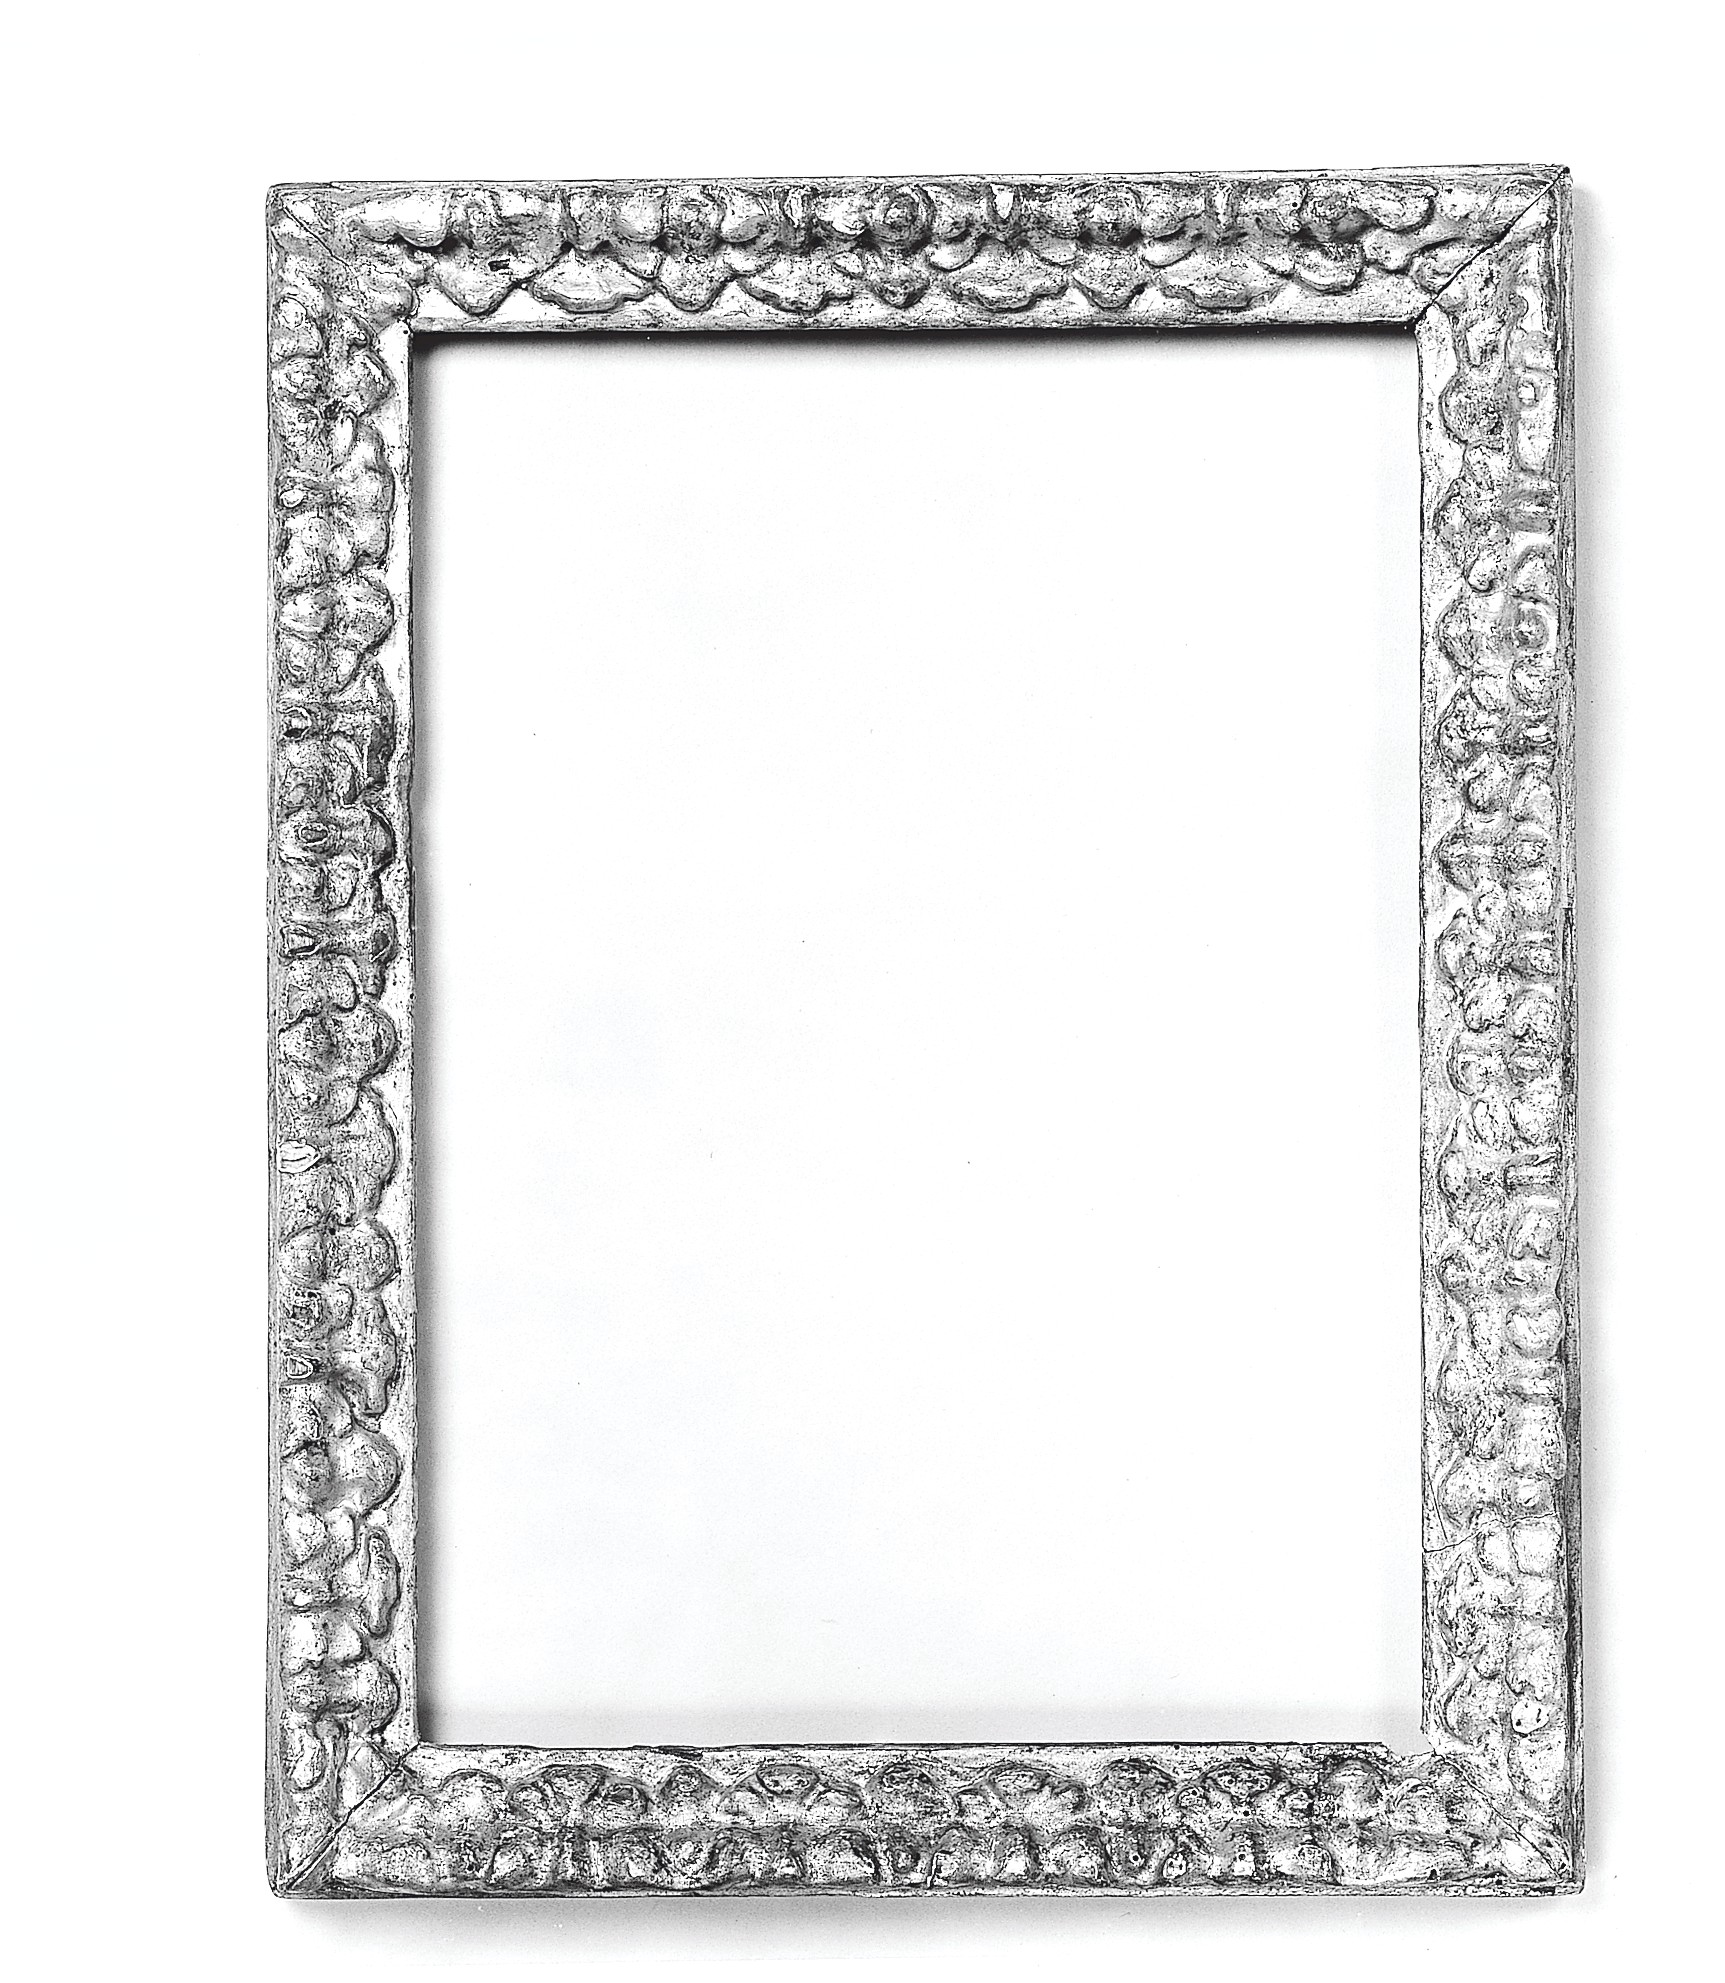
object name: frame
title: Fragment of Salvator Rosa frame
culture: italian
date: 1660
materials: wood